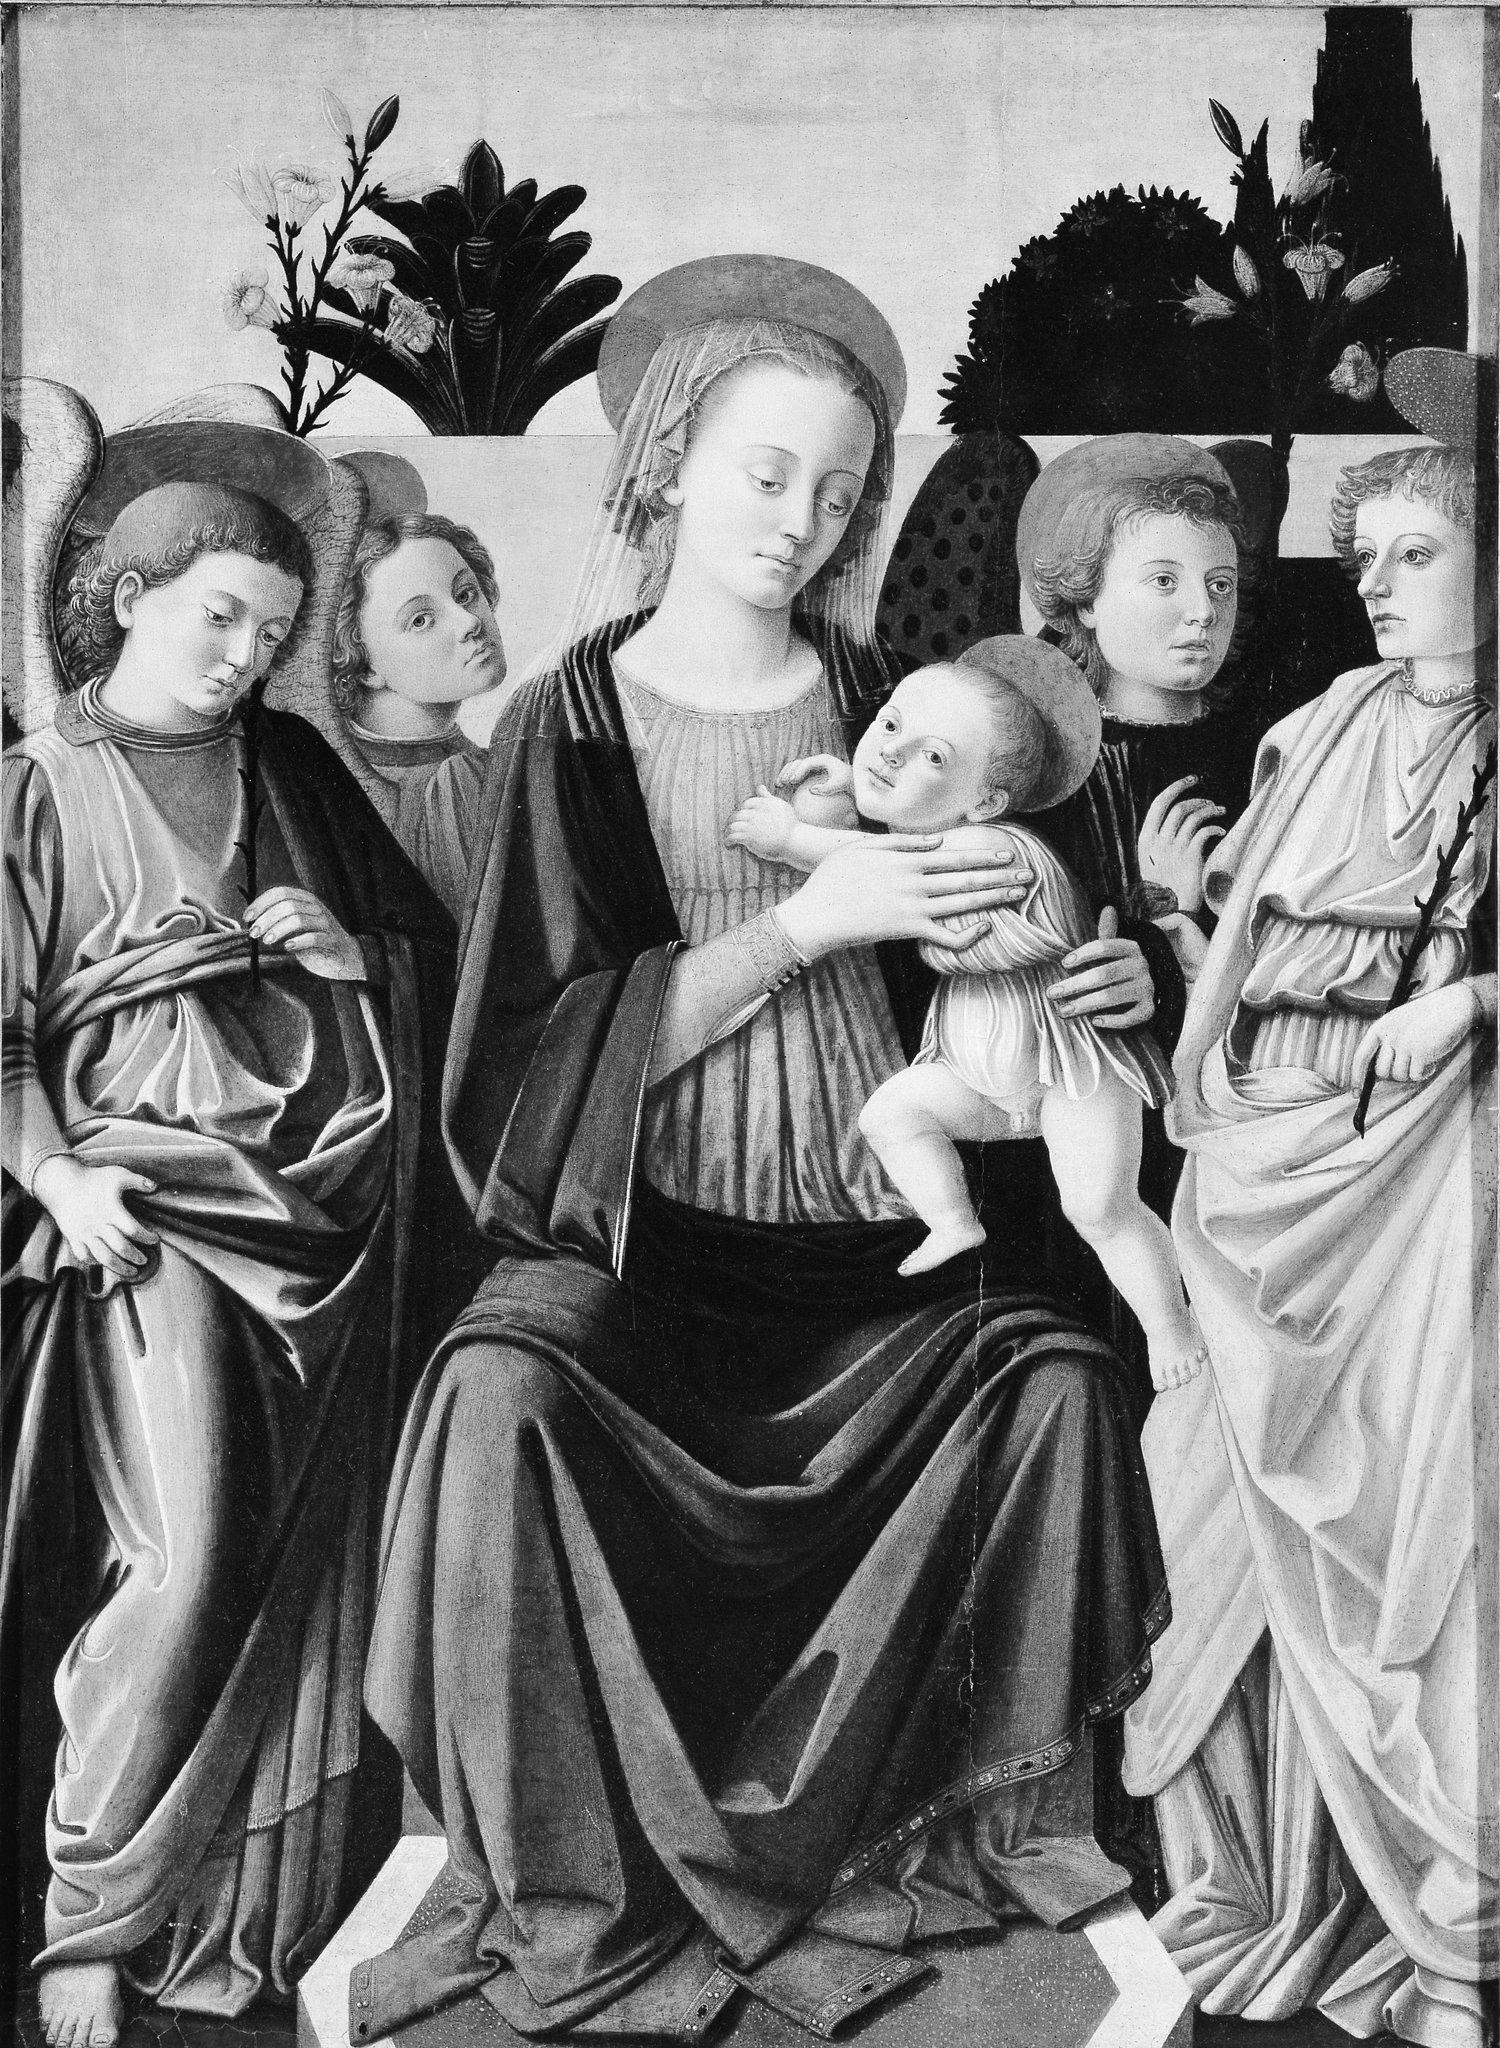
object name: painting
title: Madonna and Child with Angels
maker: italian (florentine) painter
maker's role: artist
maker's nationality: italian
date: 1450-1474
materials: oil, wood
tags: angels,madonna and child,nursing